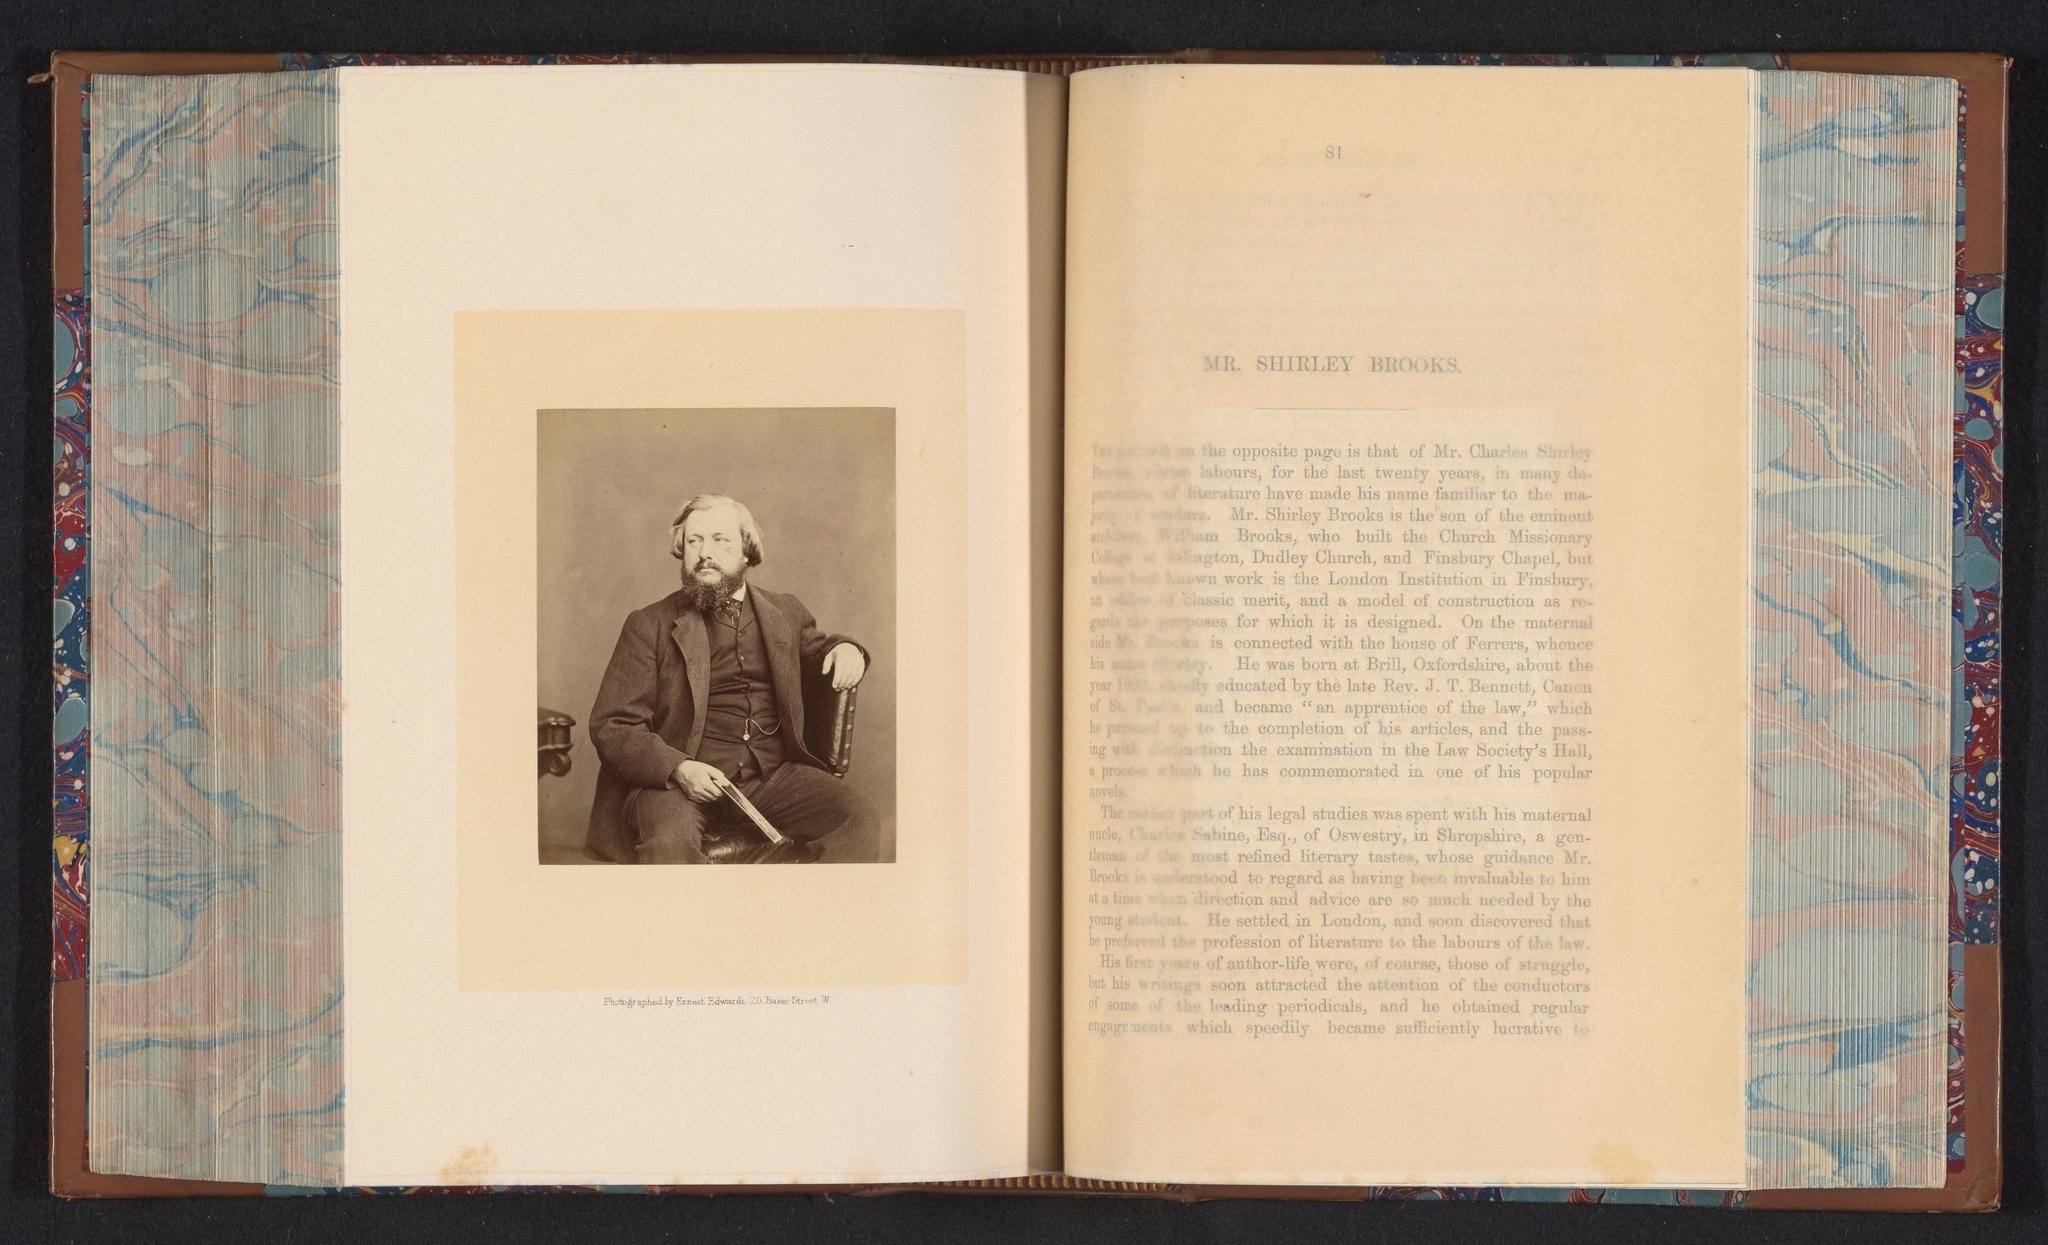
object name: page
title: Portret van Shirley Brooks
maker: ernest edwards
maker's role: fotograaf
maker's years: 1837-1903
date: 1856-1866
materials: photographic support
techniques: albumen print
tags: studio requisites ~ photographer, journalist, reporter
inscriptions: name: ‘Photographed by Ernest Edwards, 20, Baker Street. W.’